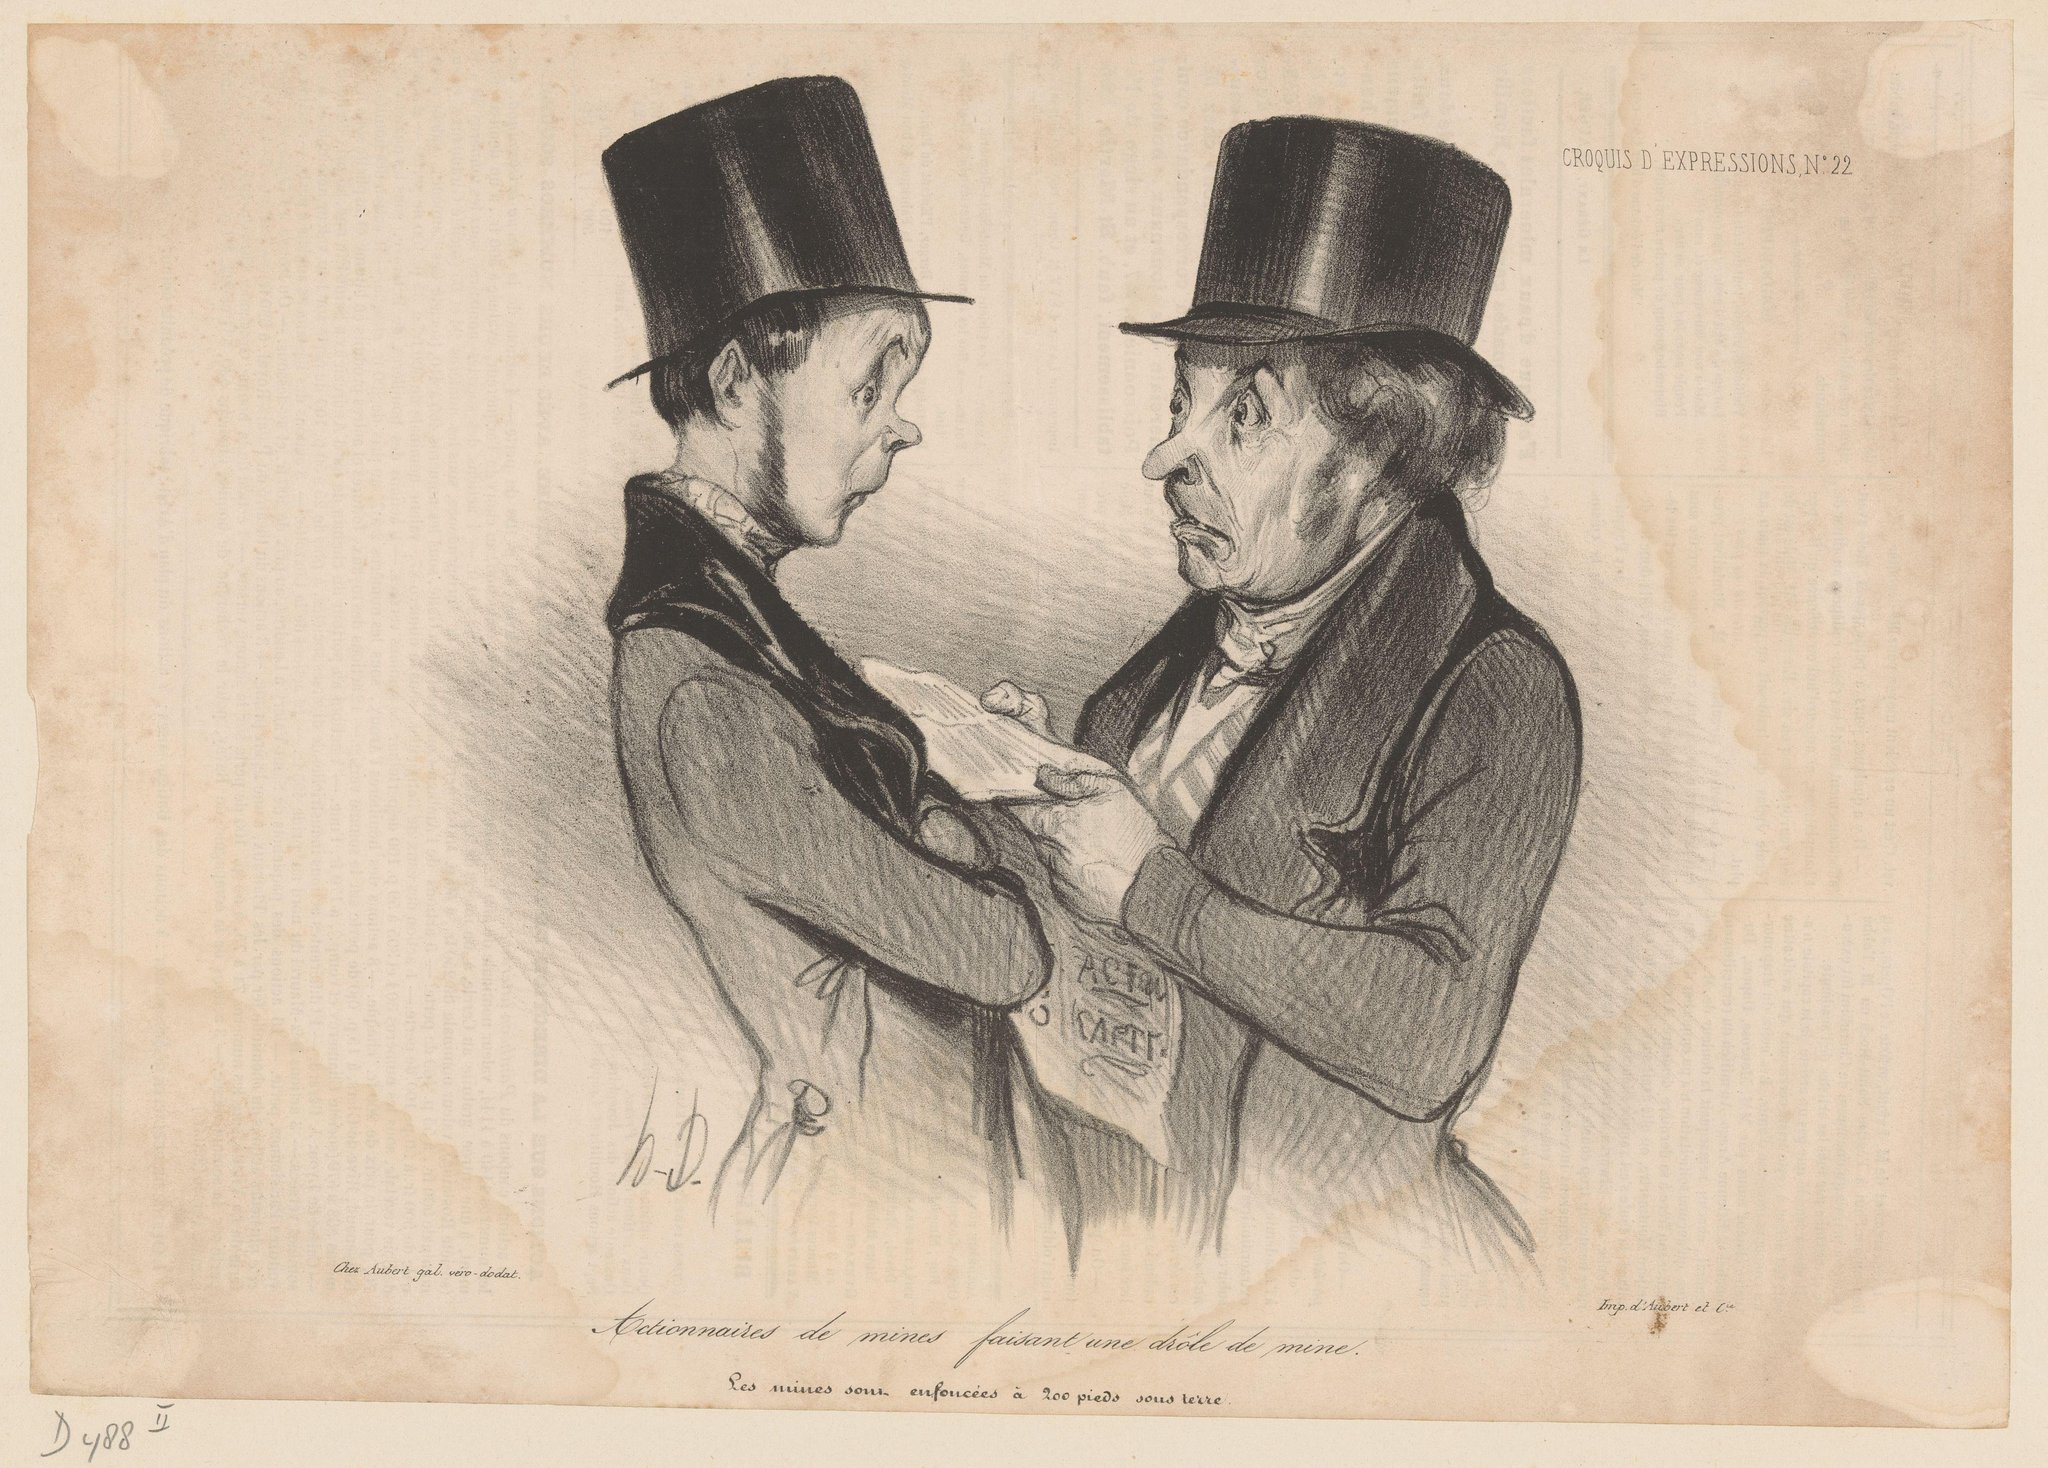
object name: cartoon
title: Actionnaires de mines (...)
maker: honoré daumier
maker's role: draughtsman, painter, print maker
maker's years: 1808-1879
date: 1838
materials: paper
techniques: letterpress printing, lithograph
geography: paris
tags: caricatures (human types), newspaper, news-sheet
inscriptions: collector's mark: Lugt 2228a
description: Prent mogelijk uit: Le Charivari, 18 augustus 1838.